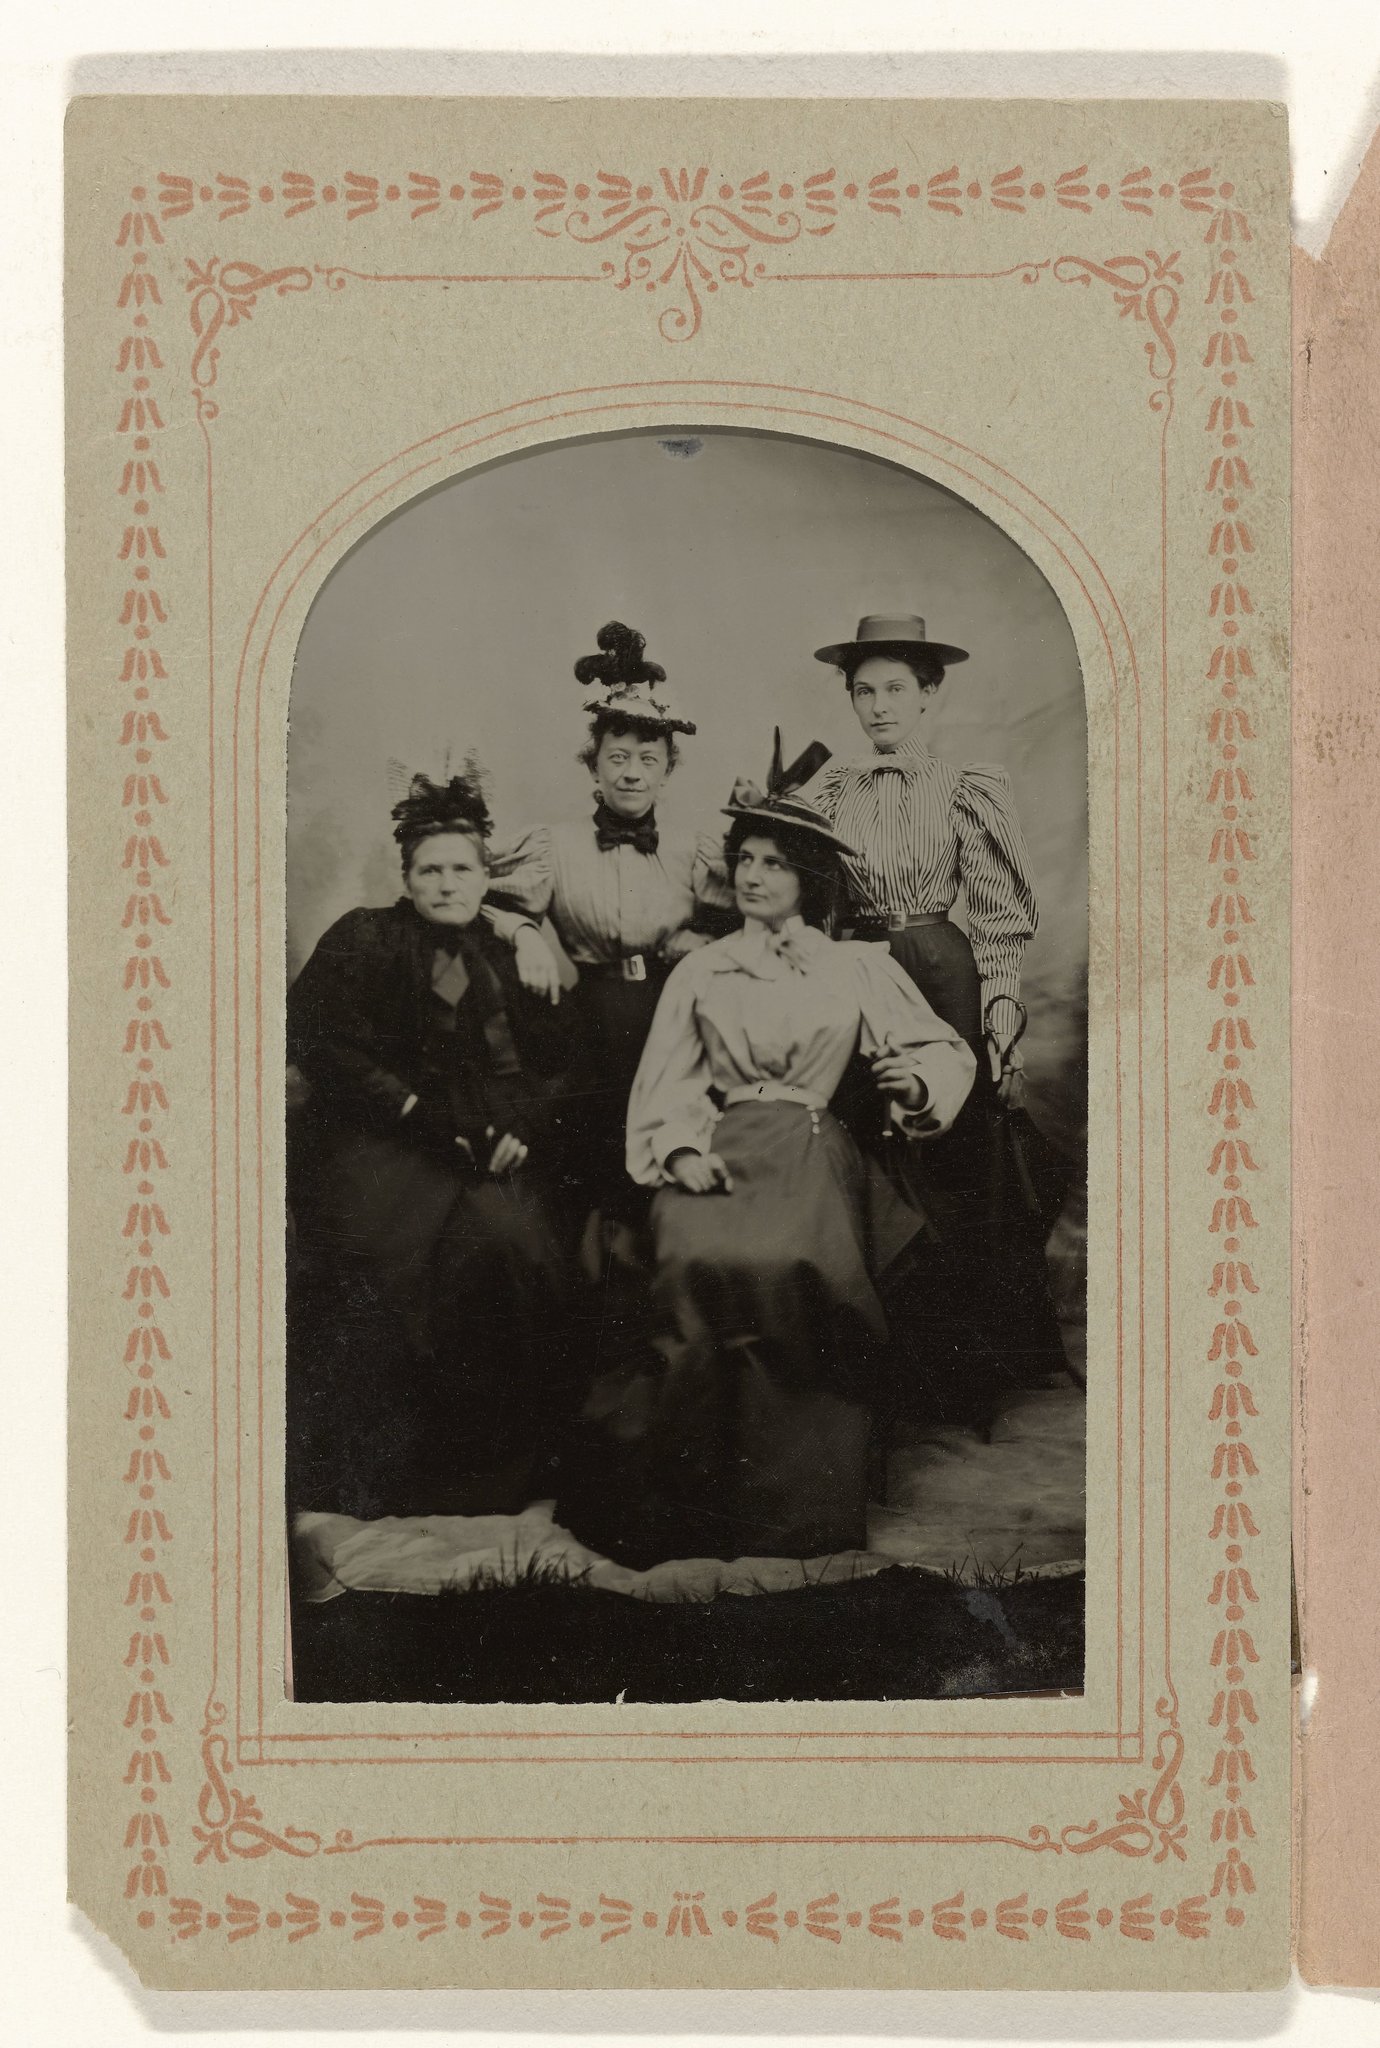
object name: photograph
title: Portret van vier vrouwen, in passepartout met gedrukte decor, van het atelier ‘Park Galleries’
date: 1890-1910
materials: metal, paper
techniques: ferrotyping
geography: sylvan beach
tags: historical persons not known by name - bb - woman, new york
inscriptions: address: ‘TIN TYPES // NEW PROCESS // THREE // PARK GALLERIES // IN ONE .// NEXT DOOR TO LARGE MERRY GO ROUND // Cottages and // Furnished Rooms to Rent. // ADDRESS Park Galleries, // Sylvan Beach, N.Y.’